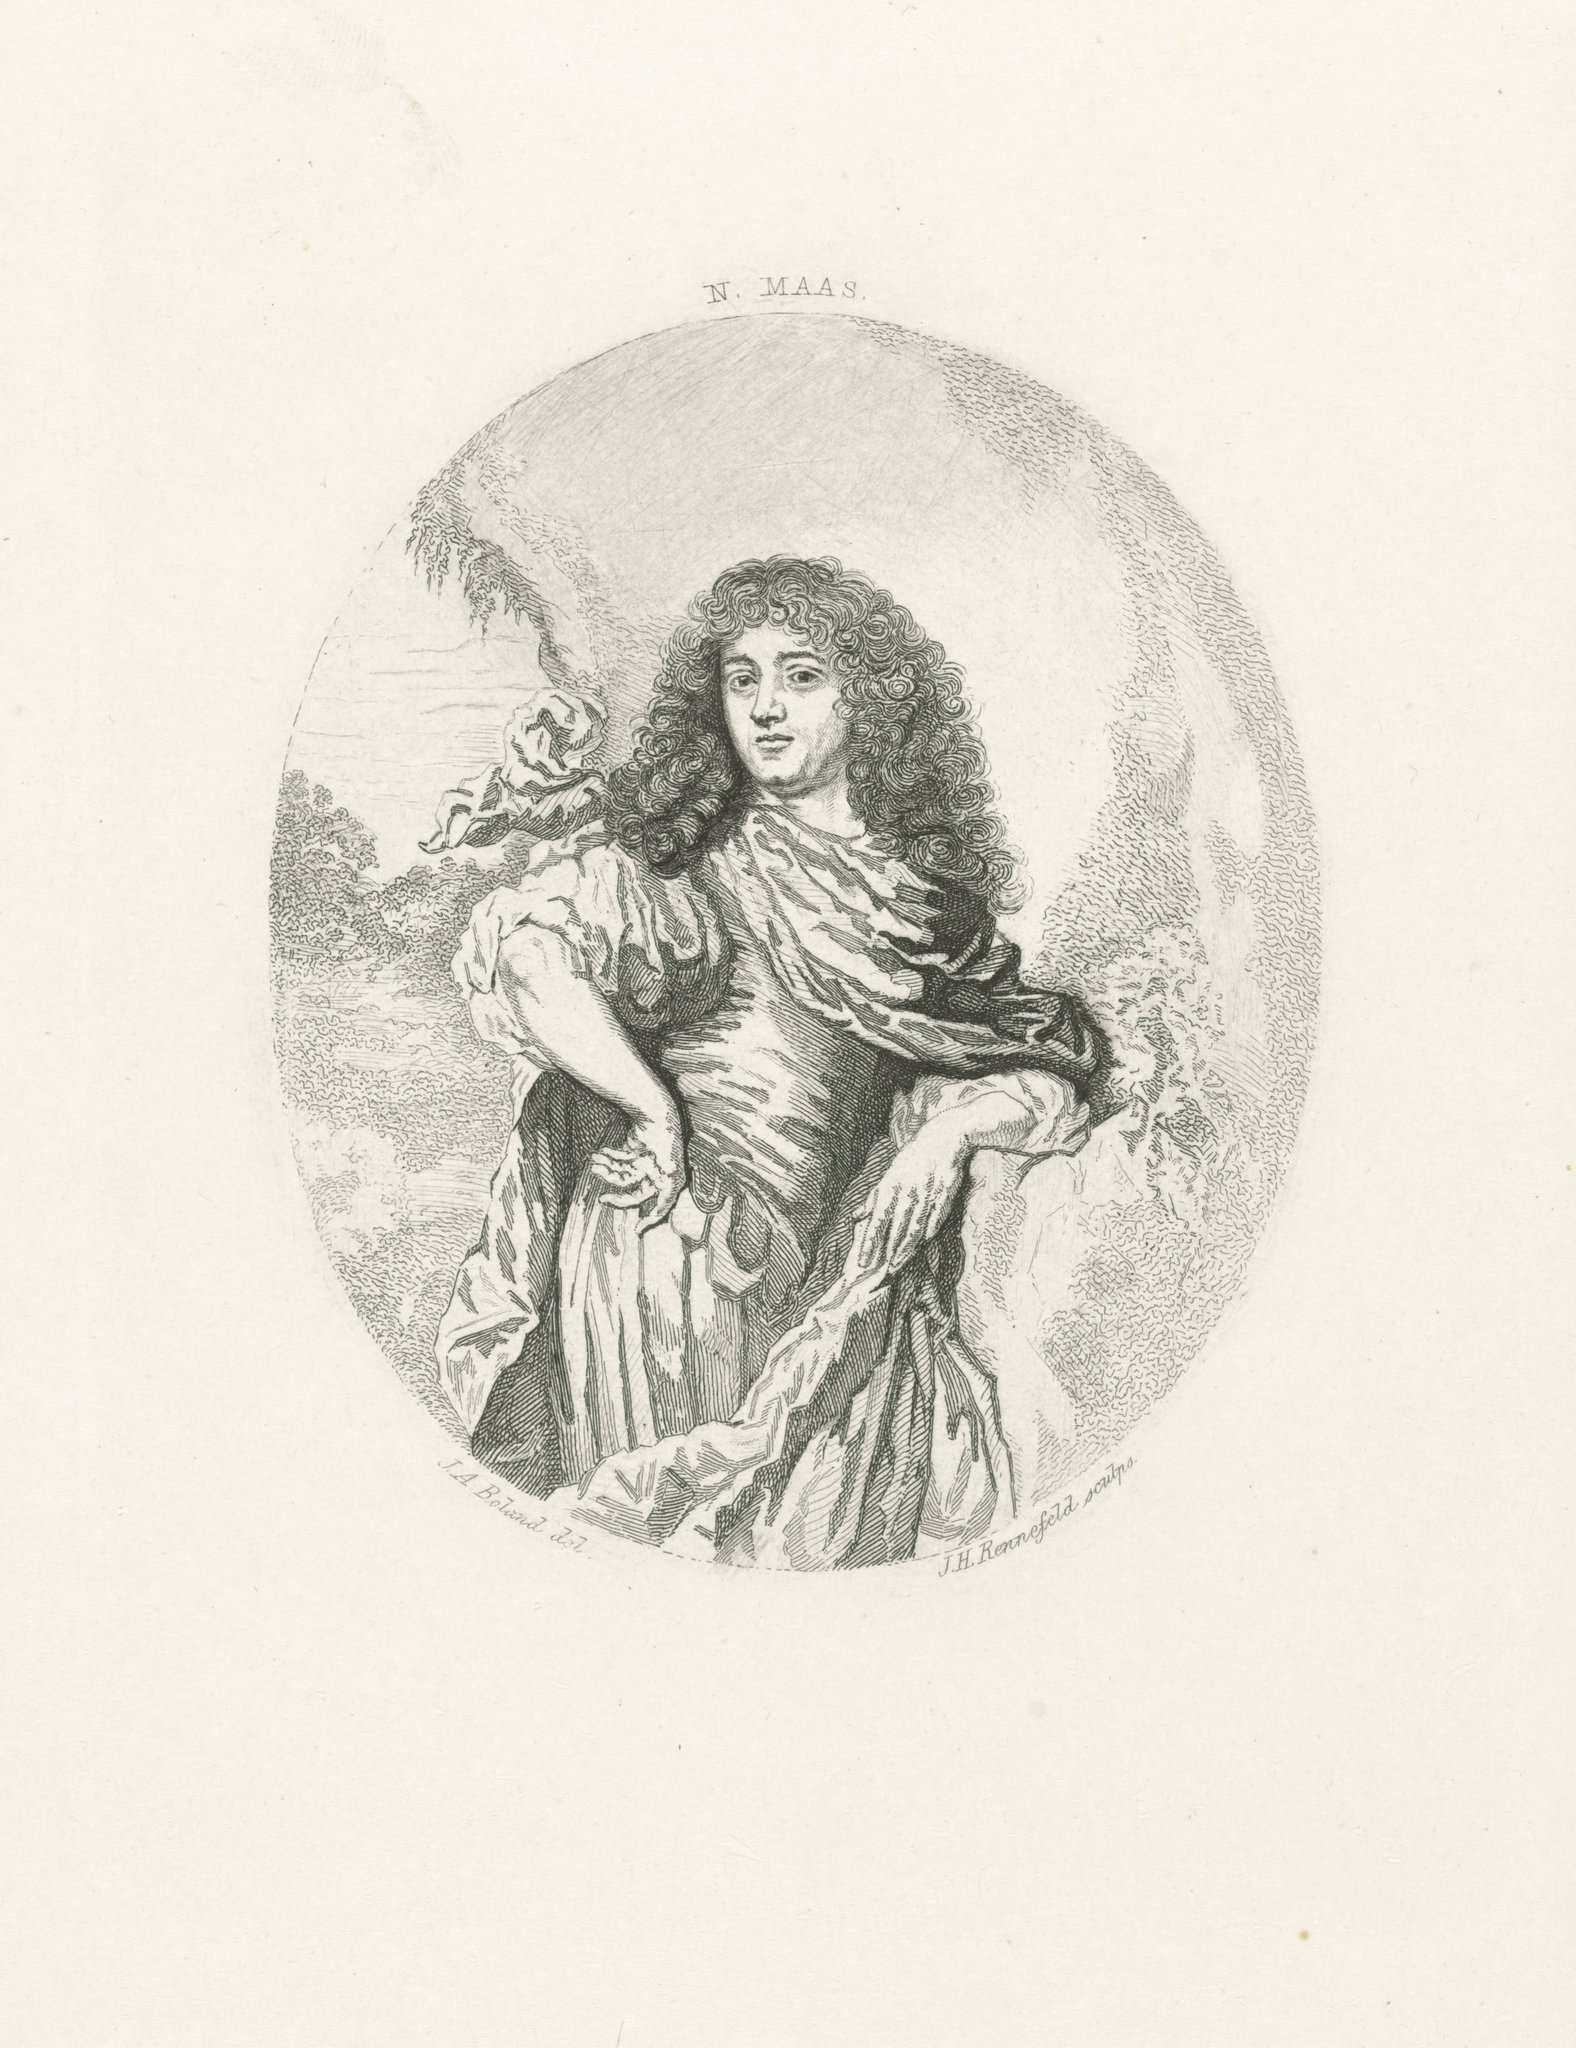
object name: print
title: Portret van een jonge man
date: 1845-1877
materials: paper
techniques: etching, roulette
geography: amsterdam